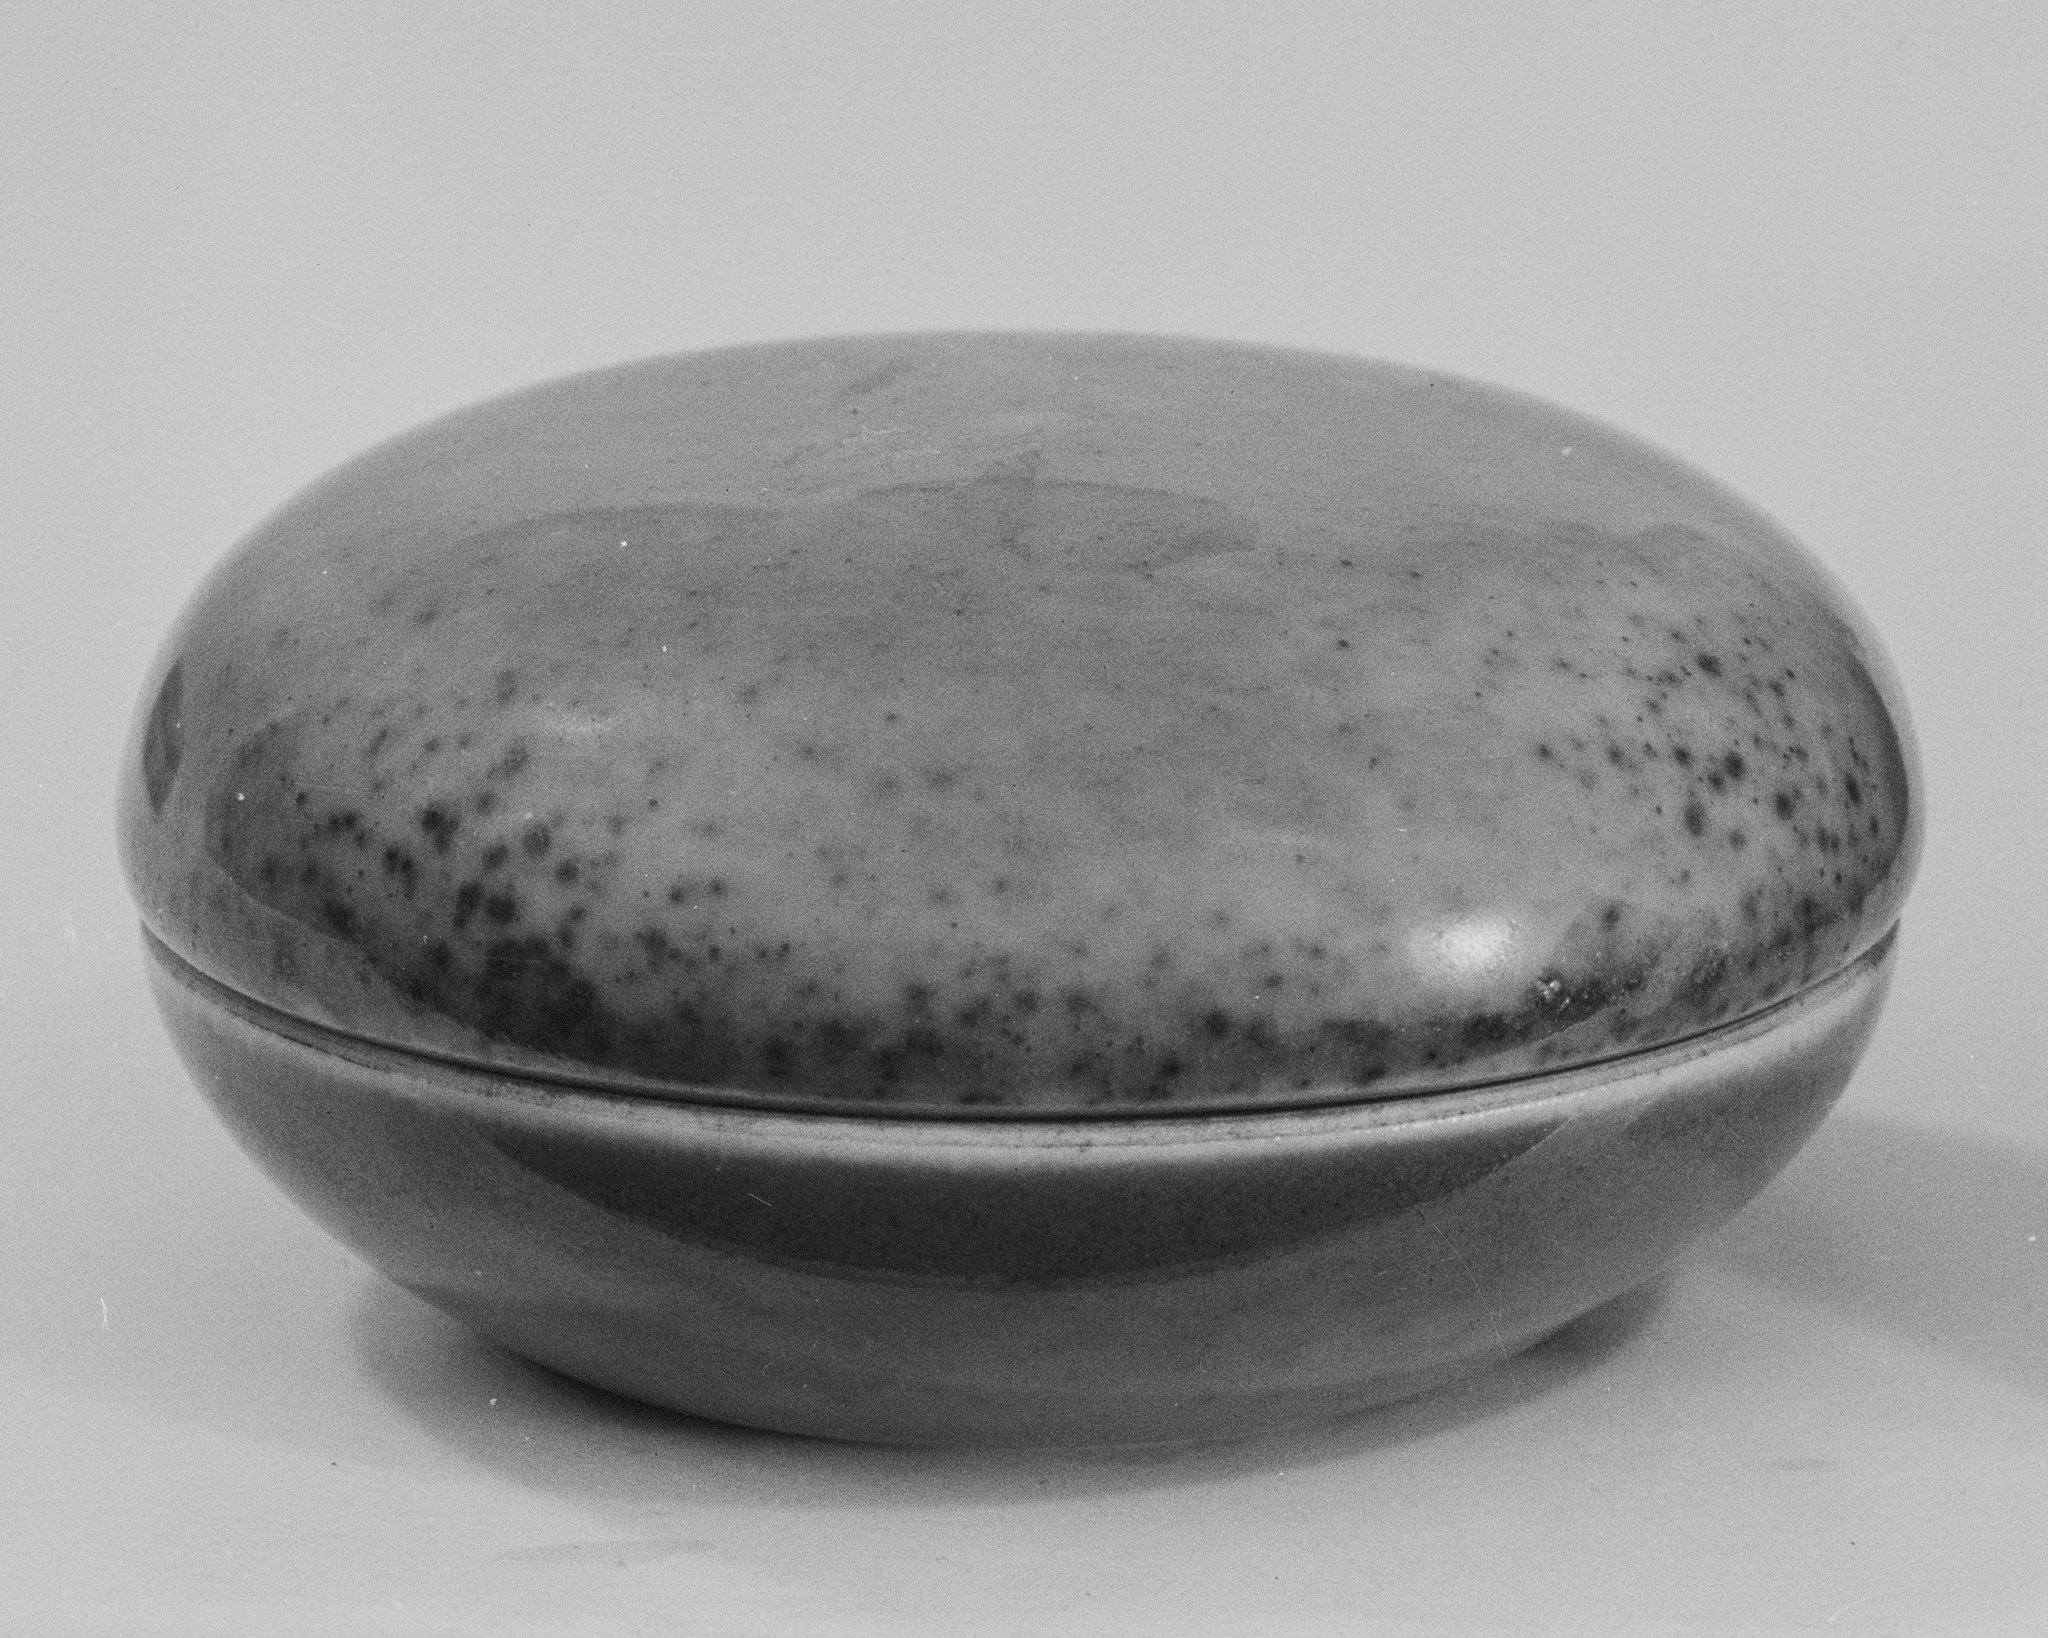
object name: covered box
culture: chinese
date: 1662-1722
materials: glaze, porcelain